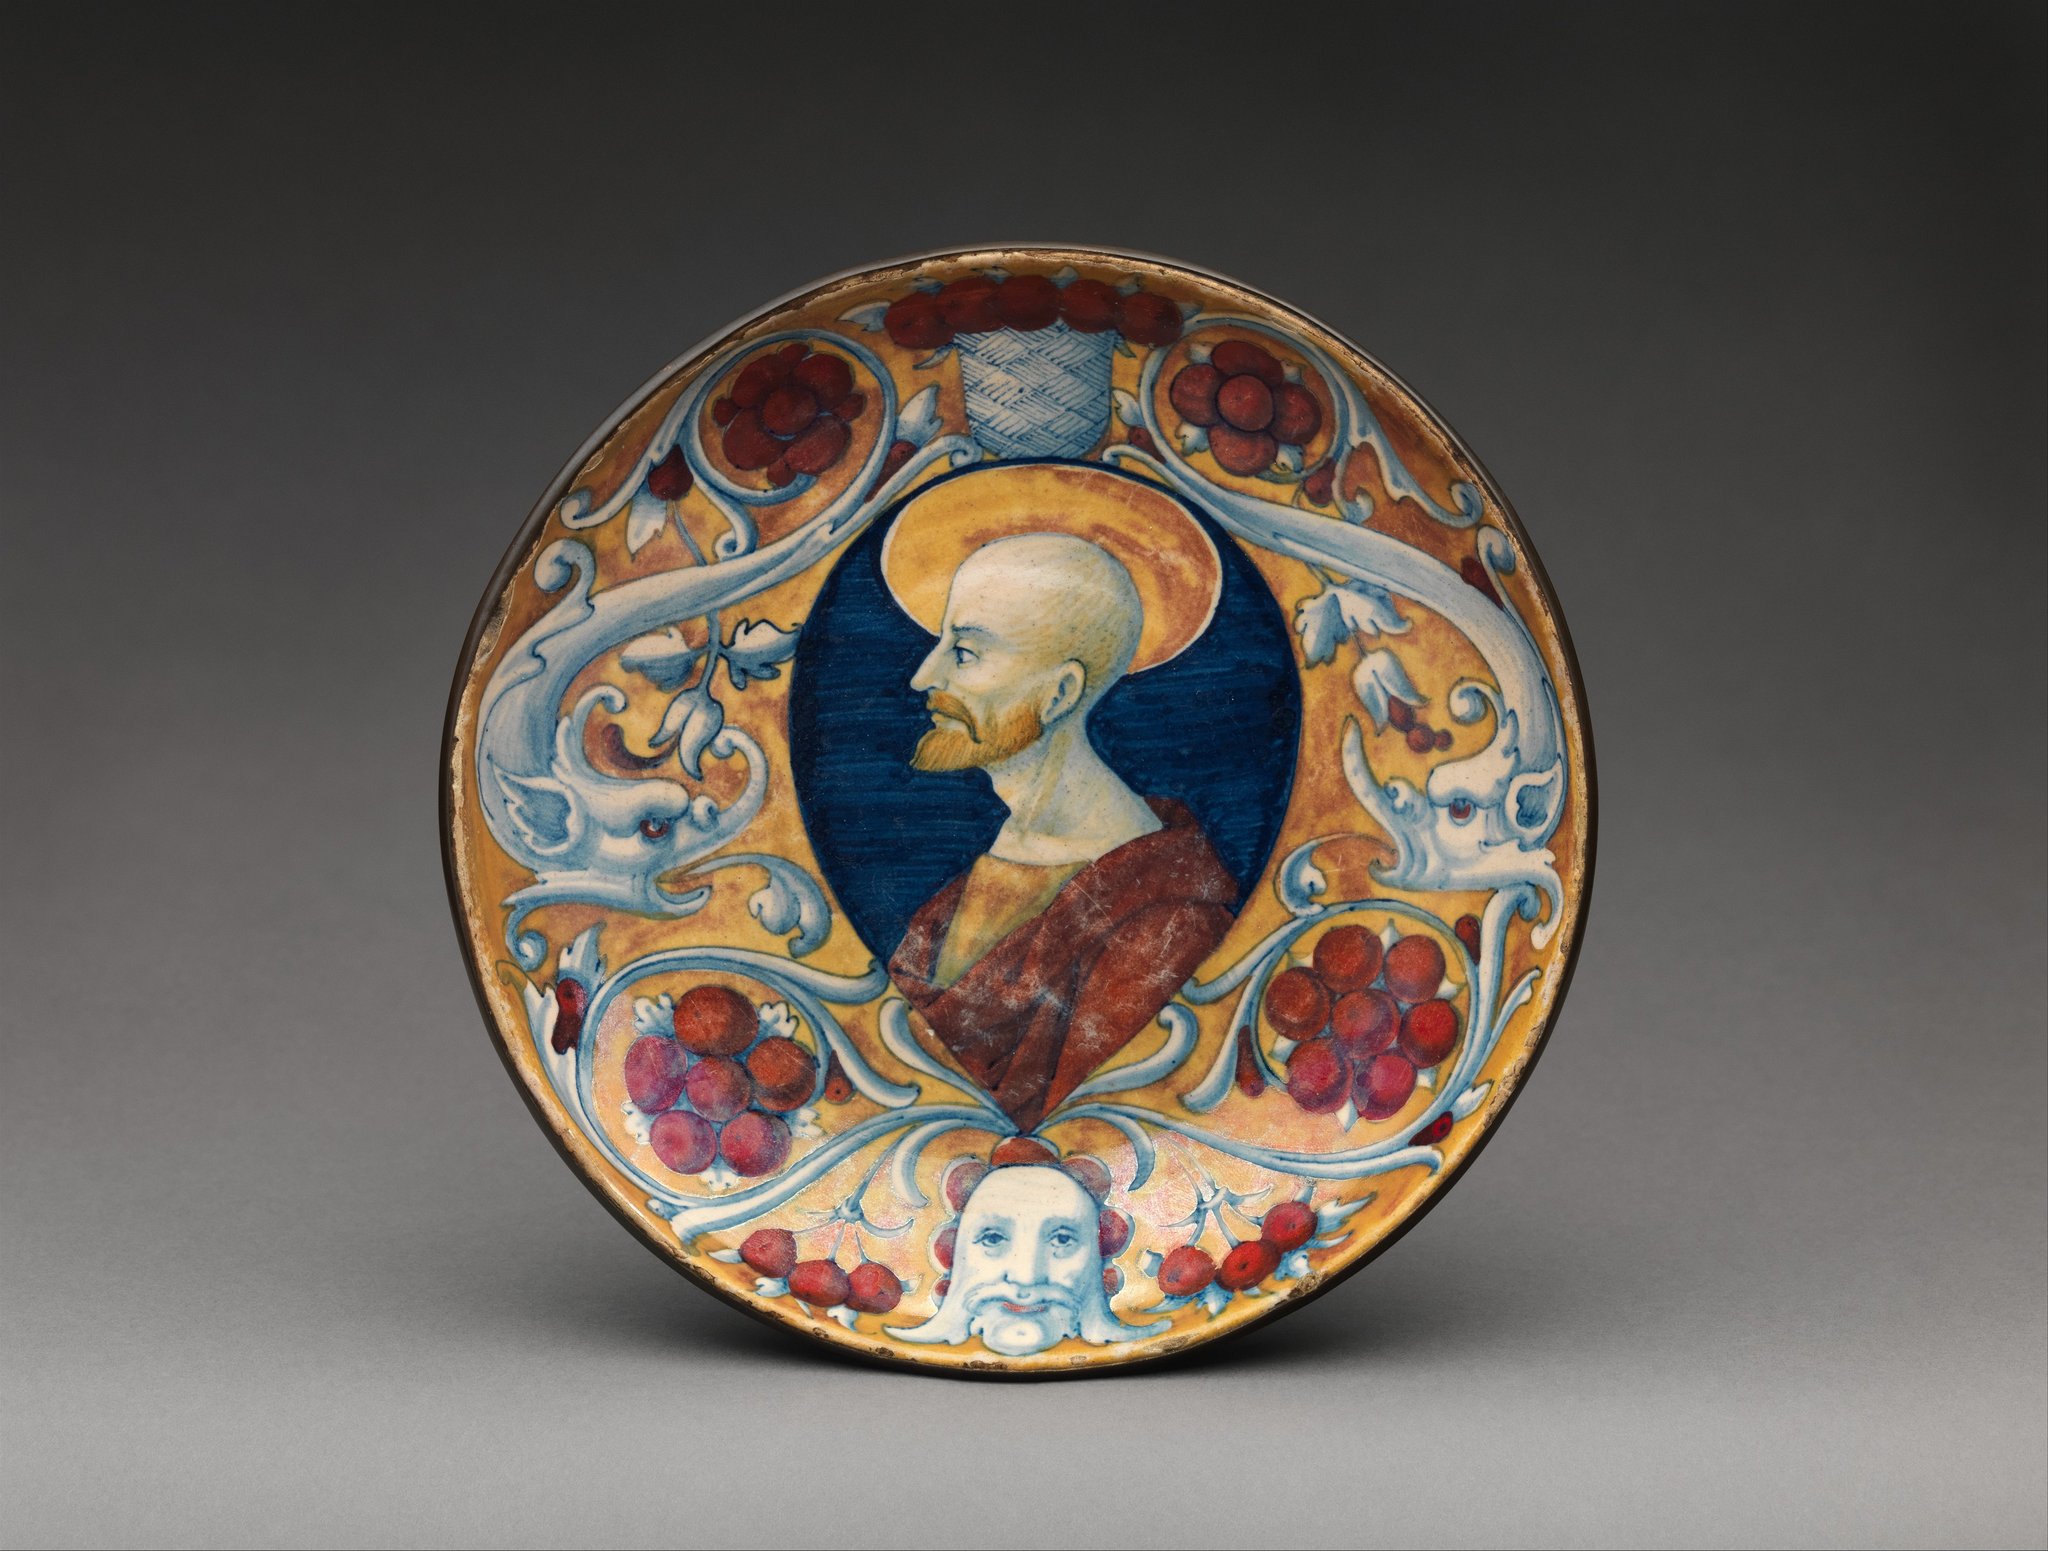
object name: bowl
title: Shallow bowl with a bearded saint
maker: maestro giorgio andreoli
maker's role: maker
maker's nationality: italian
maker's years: 1500-1550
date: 1520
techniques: maiolica, glazing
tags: men,profiles,dolphins,saints